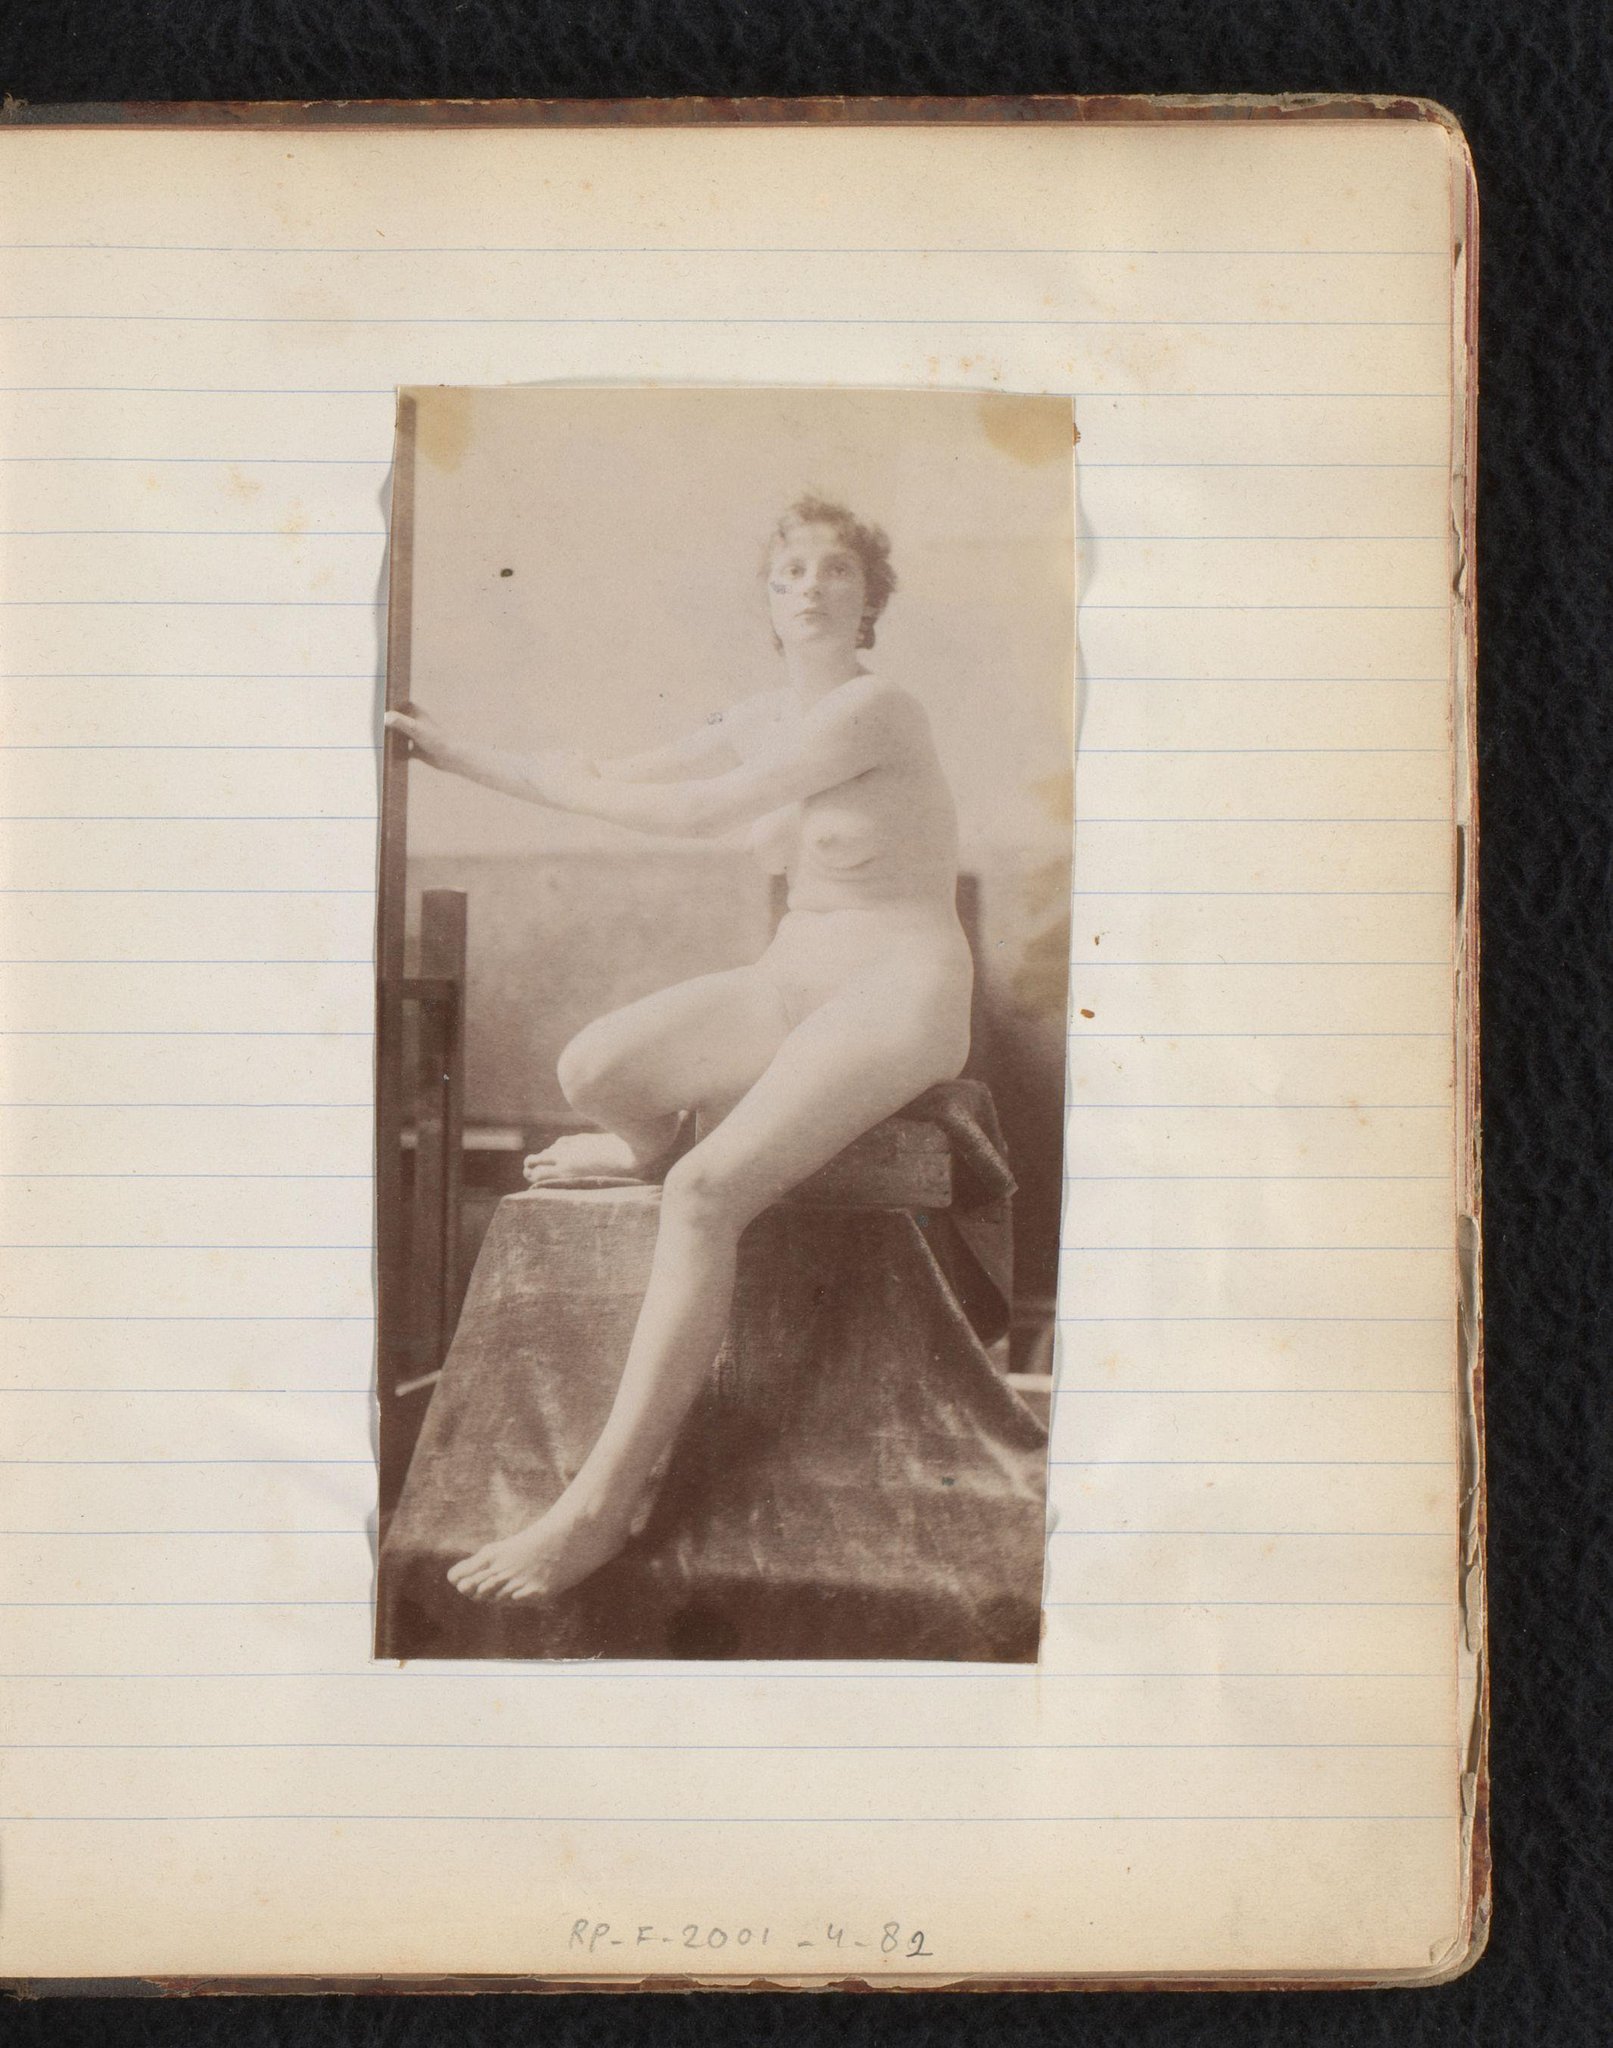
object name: album leaf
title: Studie van een vrouwelijk naaktmodel, zittend op podium en van voren gezien, in het atelier van Jacques de Lalaing, voorstudie voor grafmonument Fernand Scribe op kerkhof van Gent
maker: jacques lalaing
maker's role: painter, sculptor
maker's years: 1858-1917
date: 1895-1898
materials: photographic support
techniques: albumen print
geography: brussels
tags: adult woman, the (nude) human figure; 'corpo humano' (ripa) (+ front view), artist (in general) working from nude model